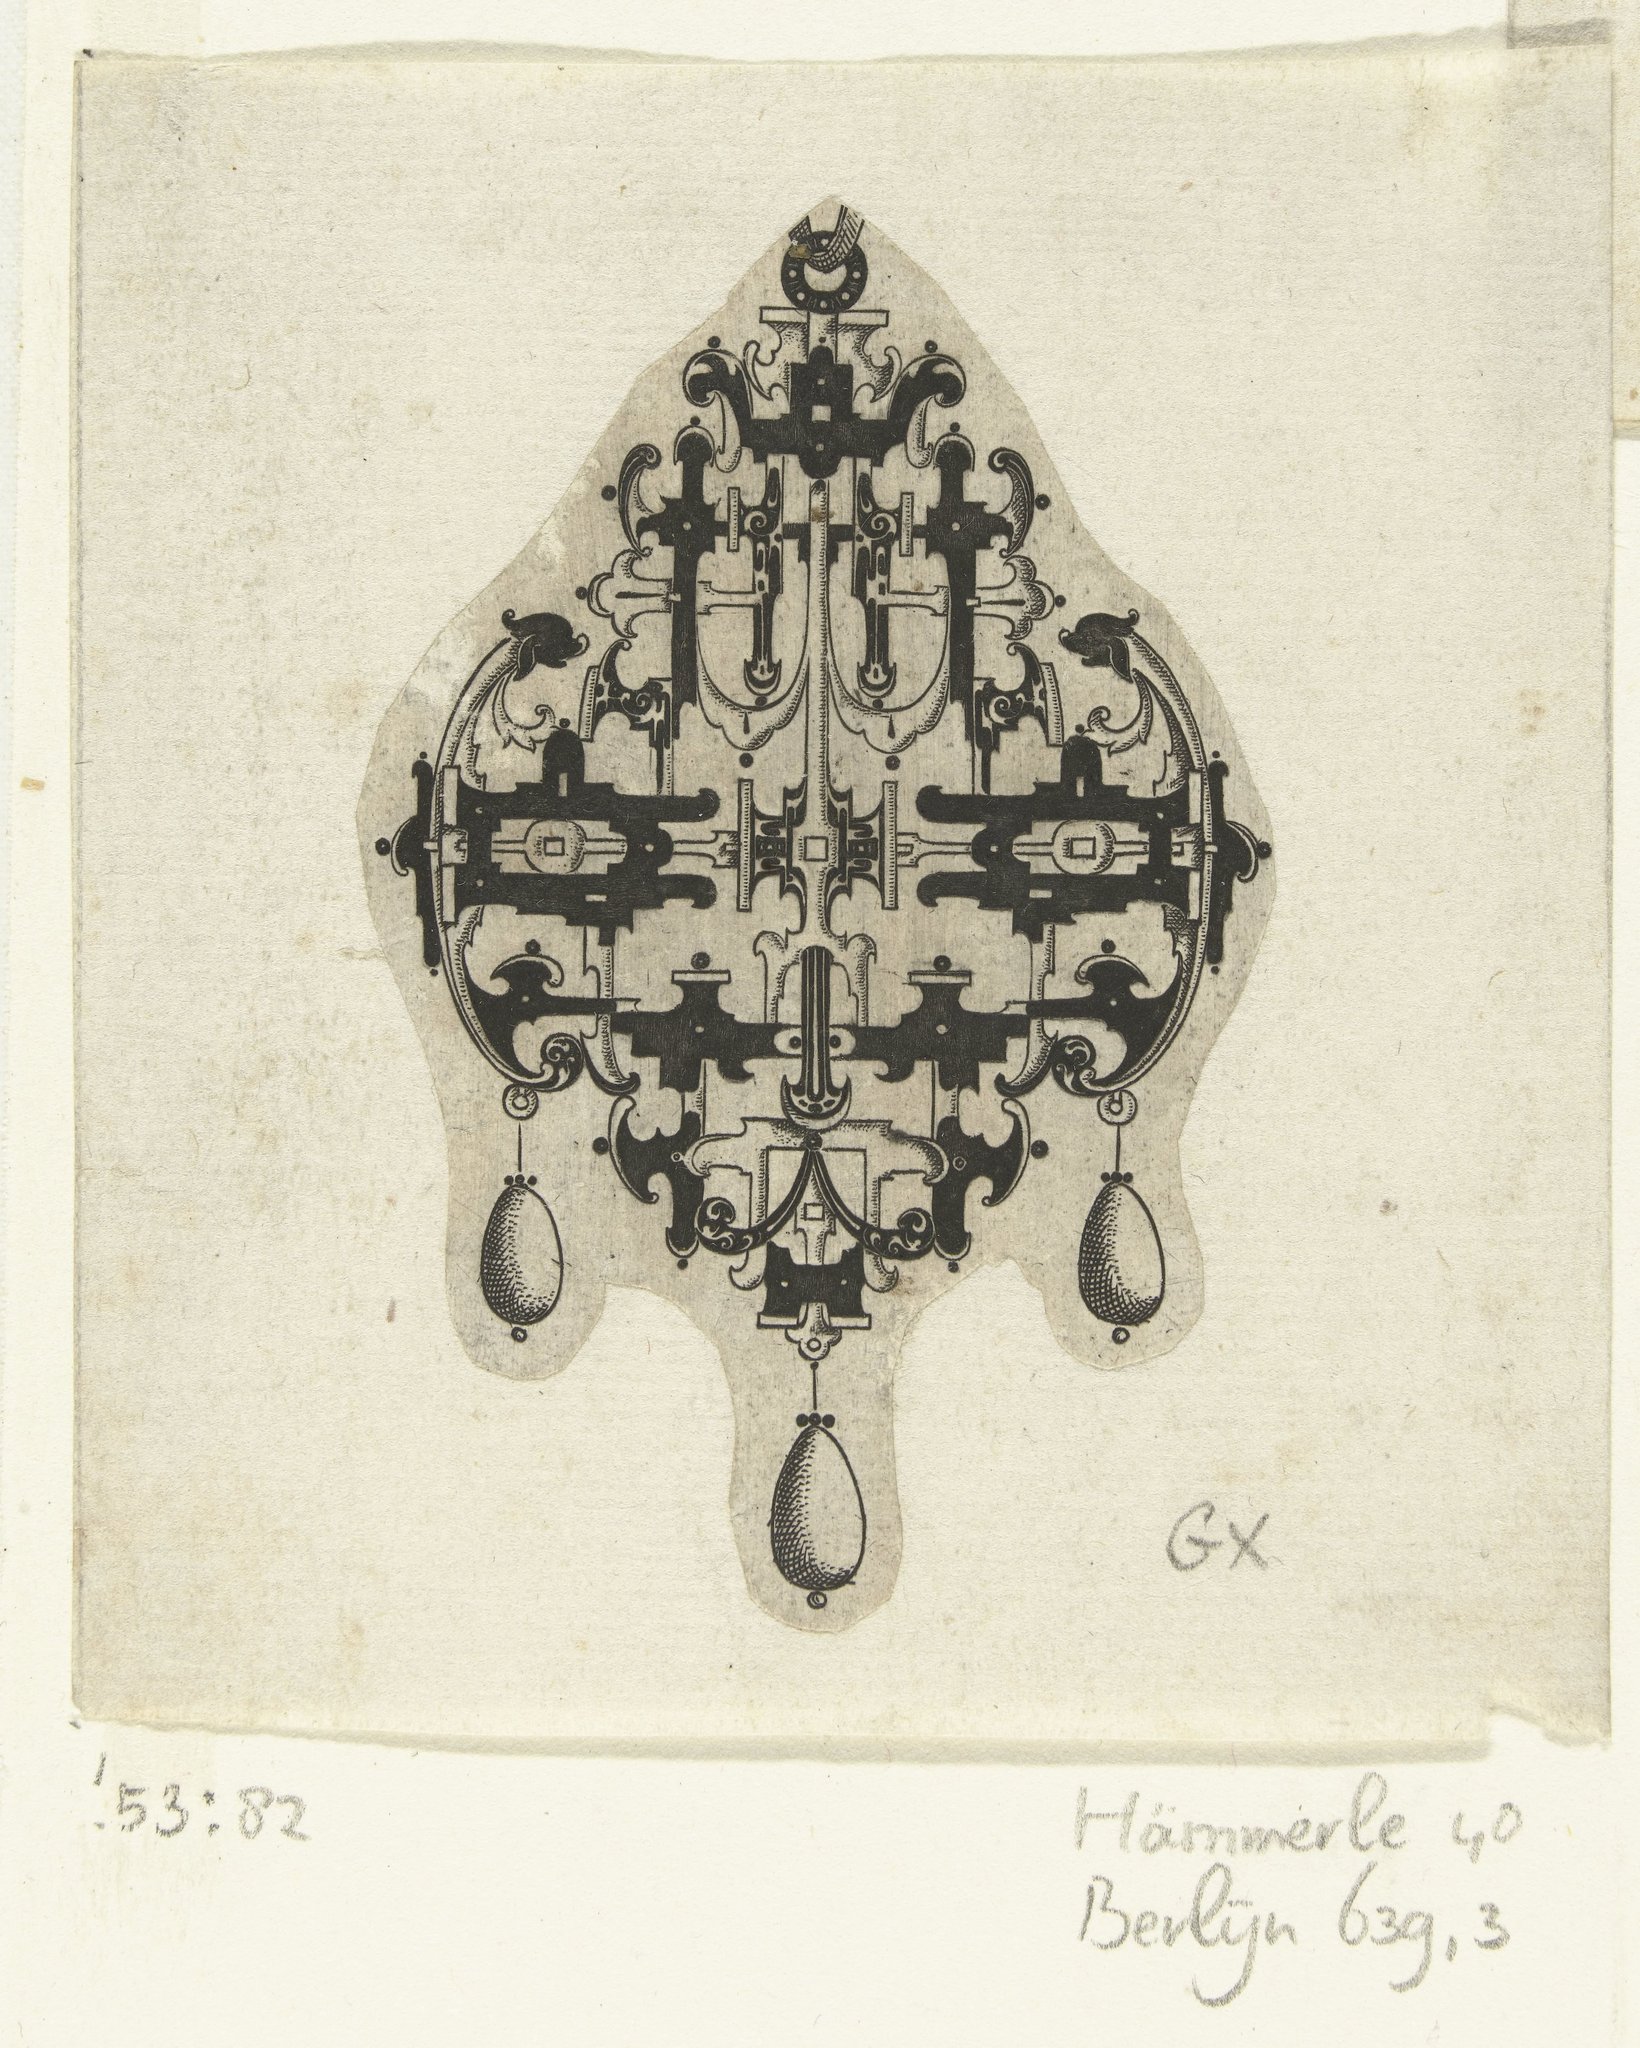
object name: ornament print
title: Hanger waarvan het krulwerk links en rechts eindigt in een silhouetachtige vissenkop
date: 1596-1616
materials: paper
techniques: engraving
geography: germany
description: Hanger met drie parels. Afkomstig uit een serie, bestaande uit een titelblad en 7 bladen met hangers.